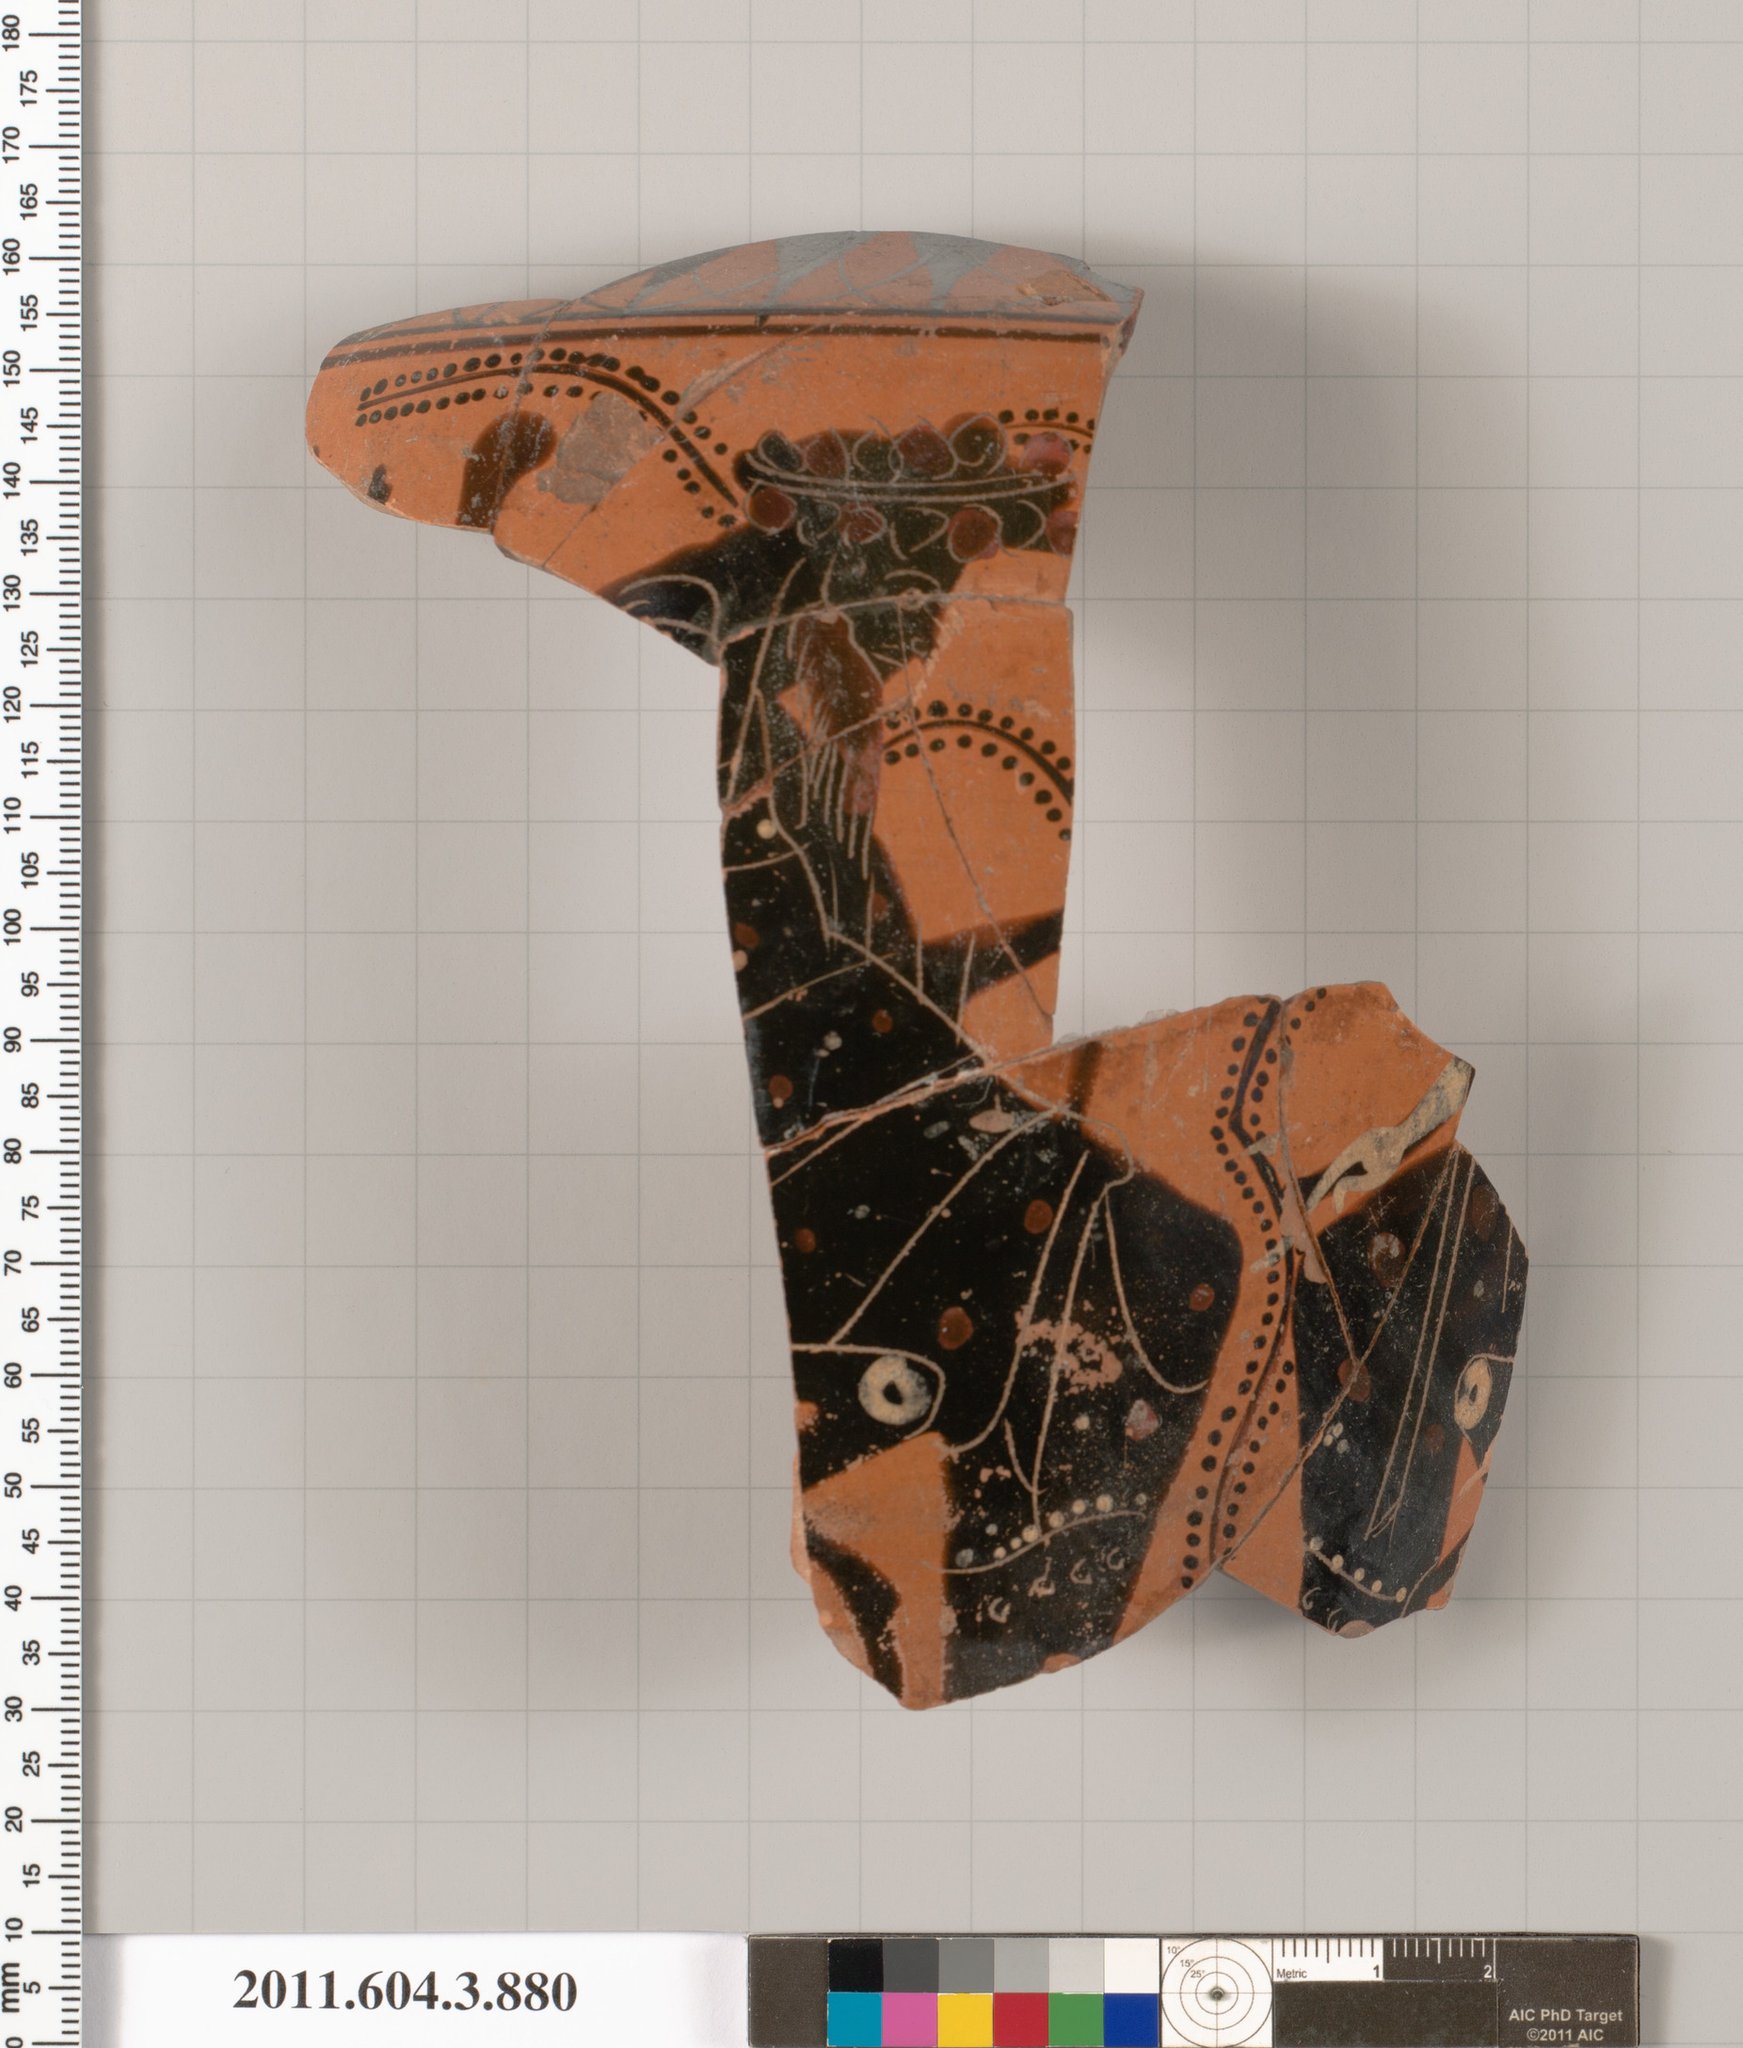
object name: lekythos fragment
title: Terracotta fragment of a lekythos (oil flask)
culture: greek, attic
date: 534-468 BCE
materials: terracotta